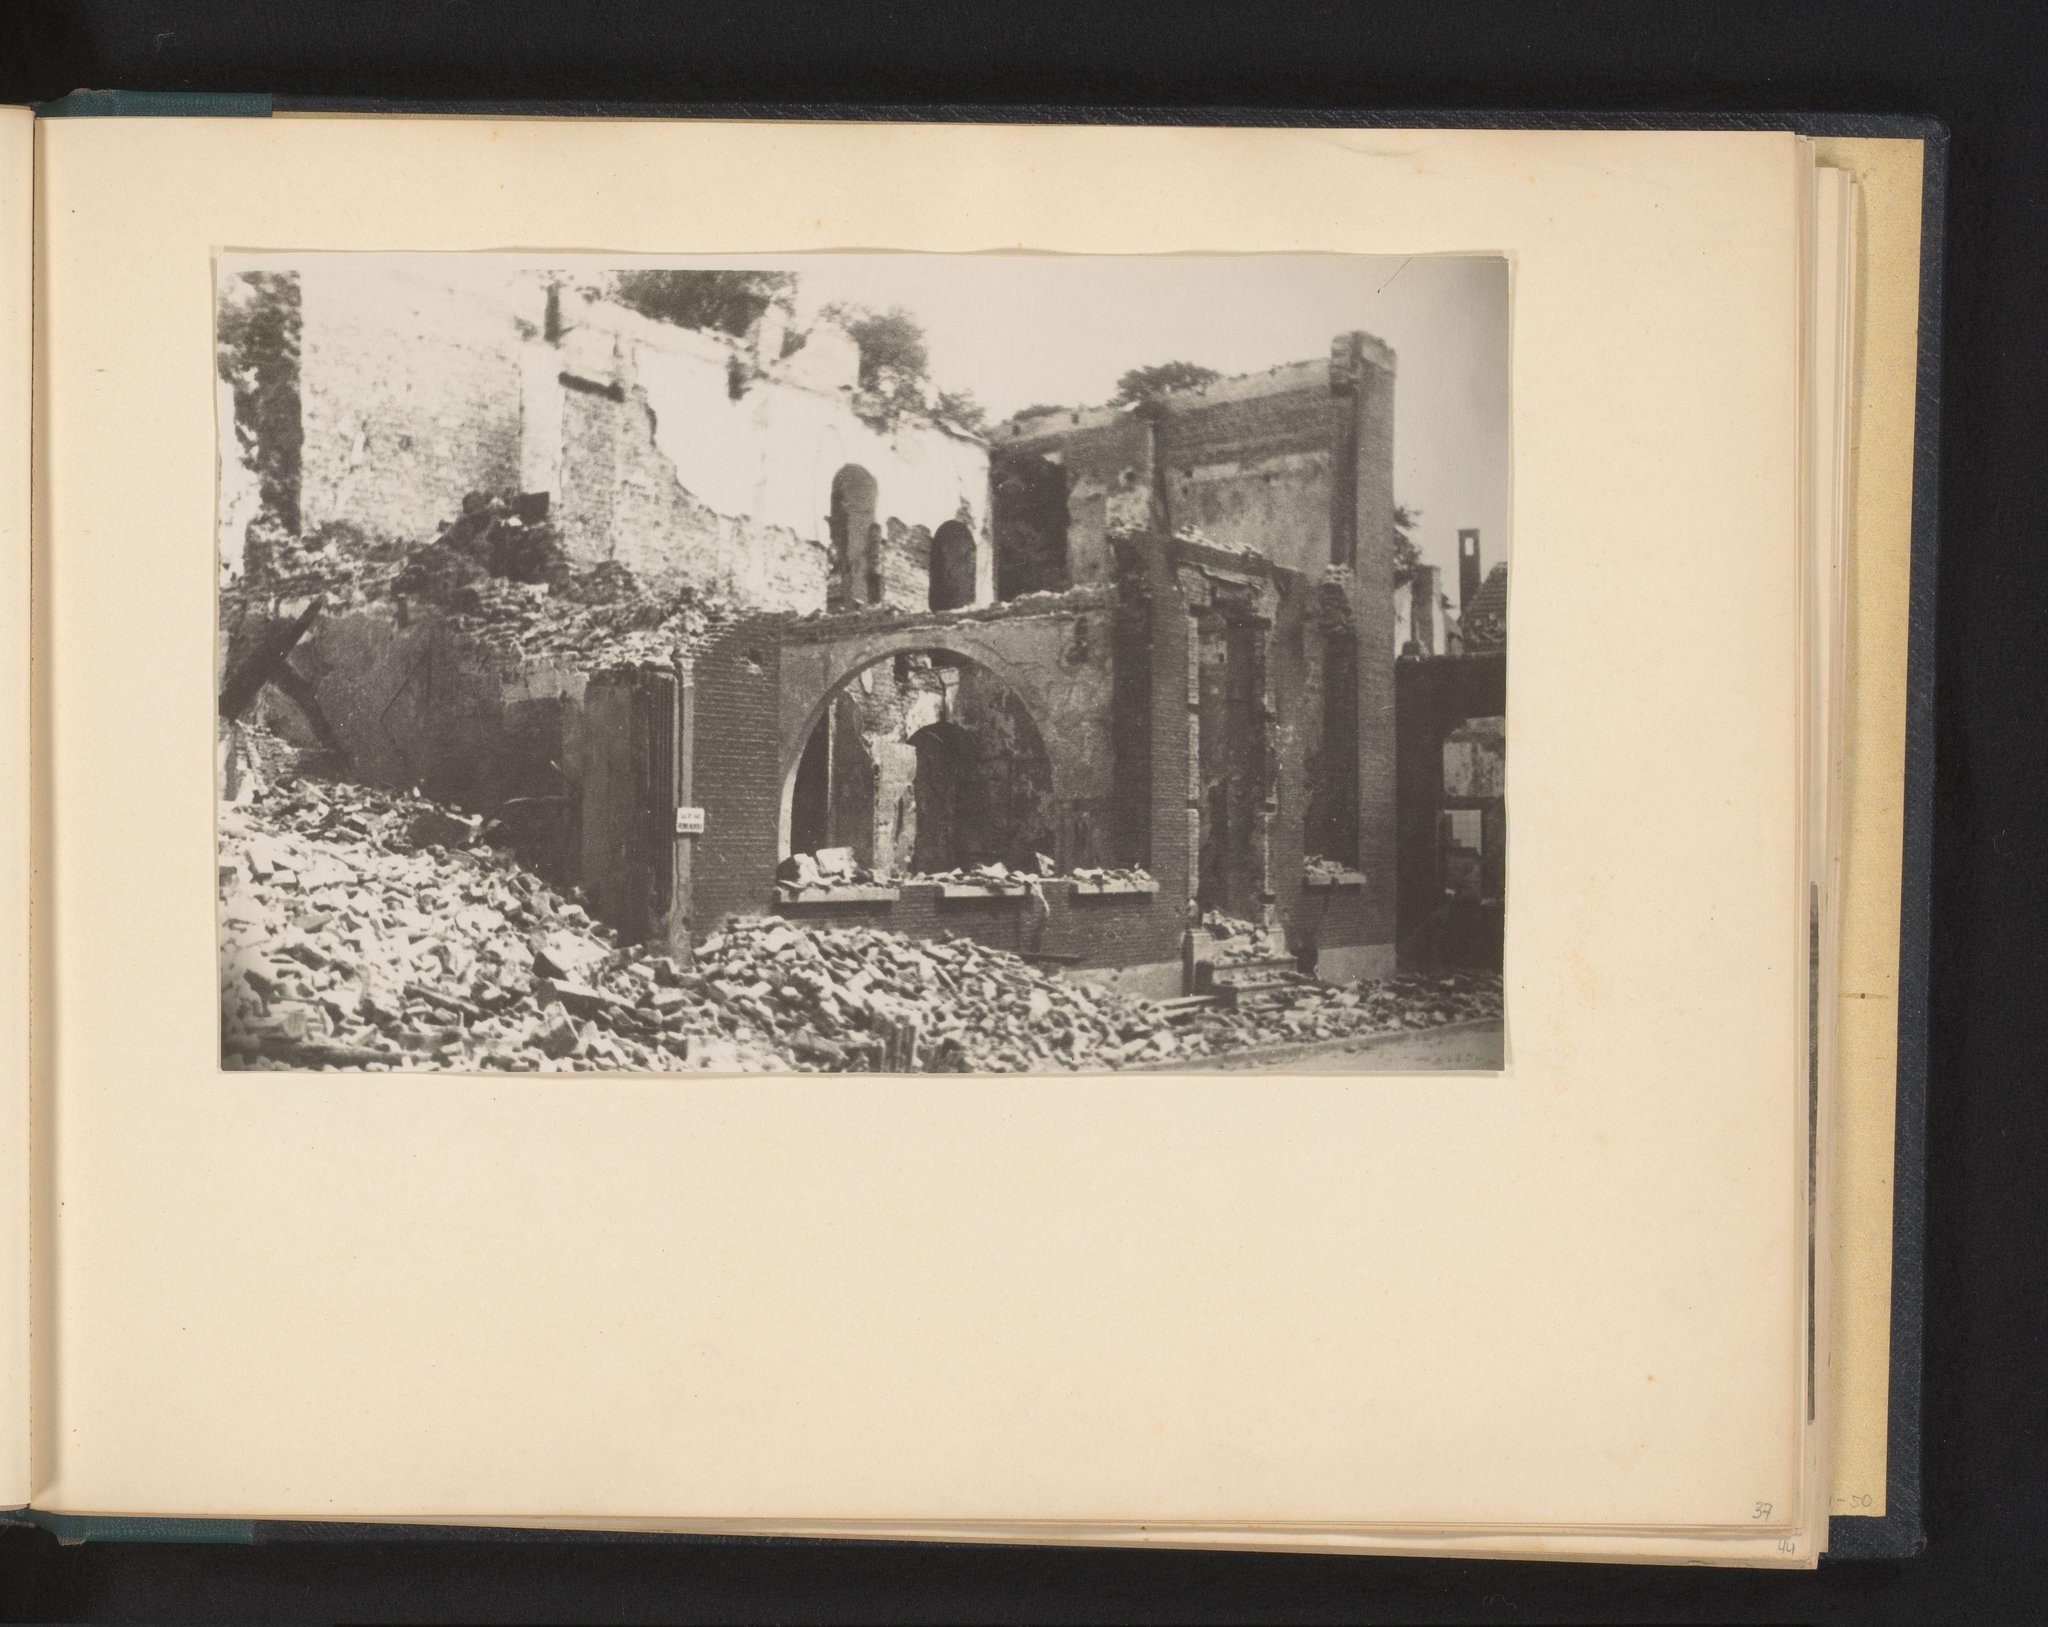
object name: photograph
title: Ruïne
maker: Anonymous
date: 1940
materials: cardboard, photographic support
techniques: gelatin silver print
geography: deventer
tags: devastated, ruined place or city (~ warfare), netherlands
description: Albumblad met een foto van de ruïne van een gebouw verwoest tijdens de Duitse inval in mei 1940. Onderdeel van het fotoalbum over de verwoestingen van Nederlandse steden en infrastructuur in het begin van de Tweede Wereldoorlog.